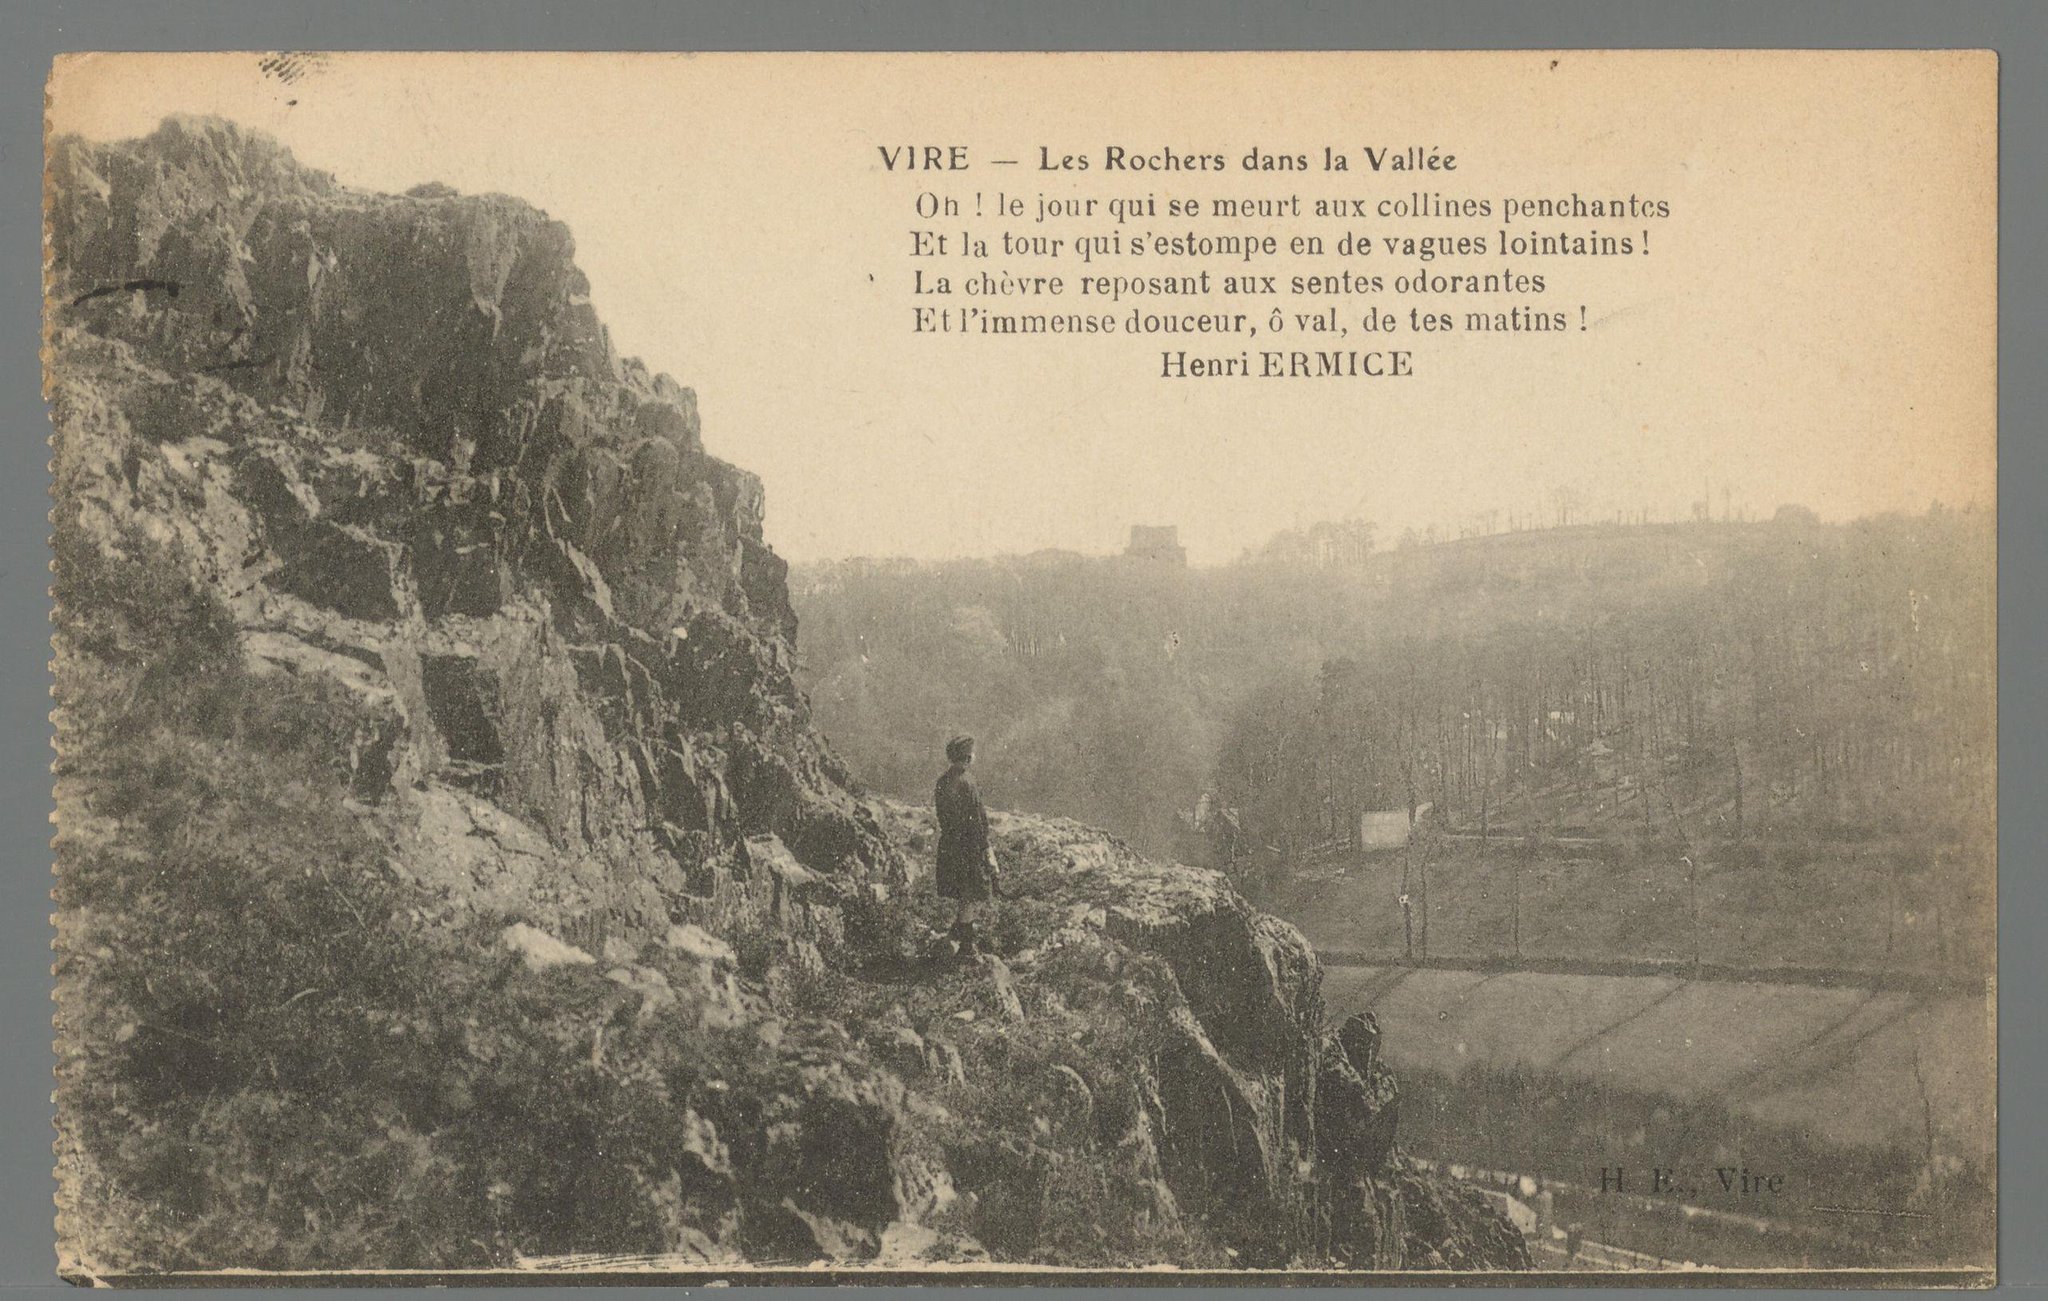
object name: ansichtkaart, prentbriefkaart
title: Vire. Les Rochers dans la Vallée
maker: Anonymous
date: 1903-1922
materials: cardboard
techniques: photograph, writing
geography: vire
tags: rock-formations (+ landscape with figures, staffage), dale, valley (+ landscape with figures, staffage)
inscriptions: postage stamp, postage stamp